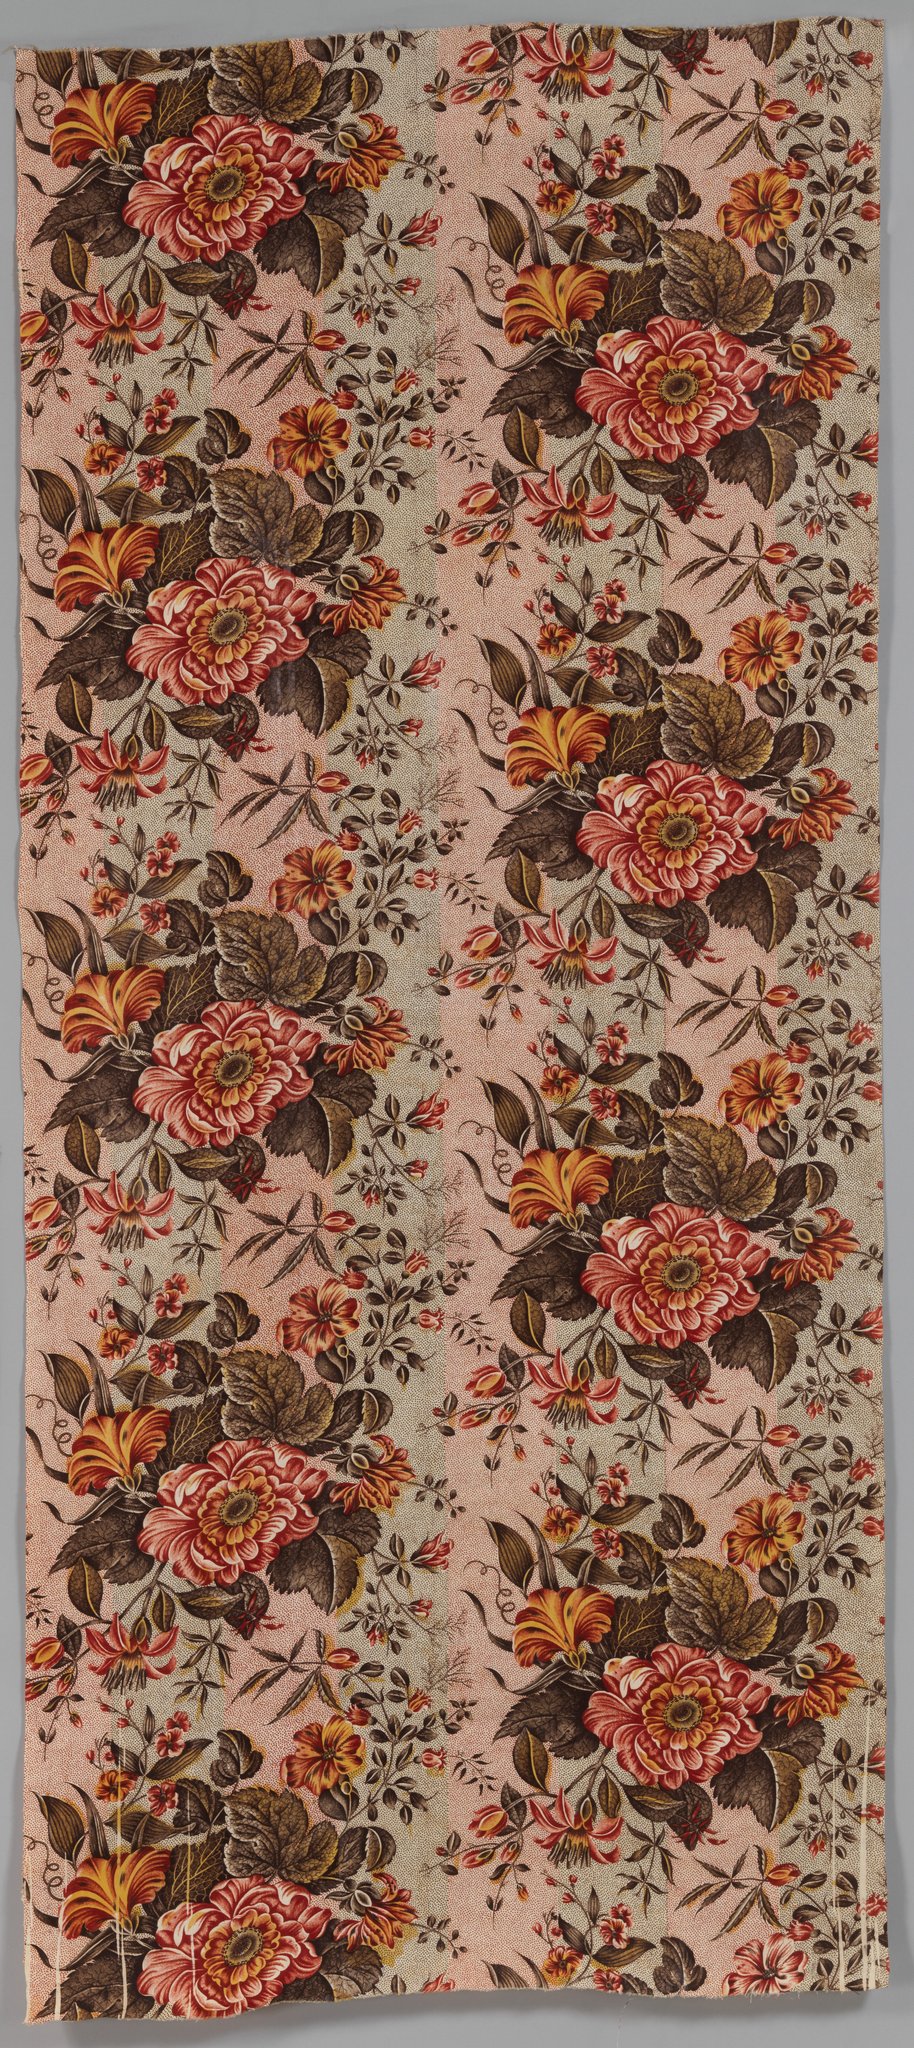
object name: piece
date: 1830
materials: cotton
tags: flowers,leaves